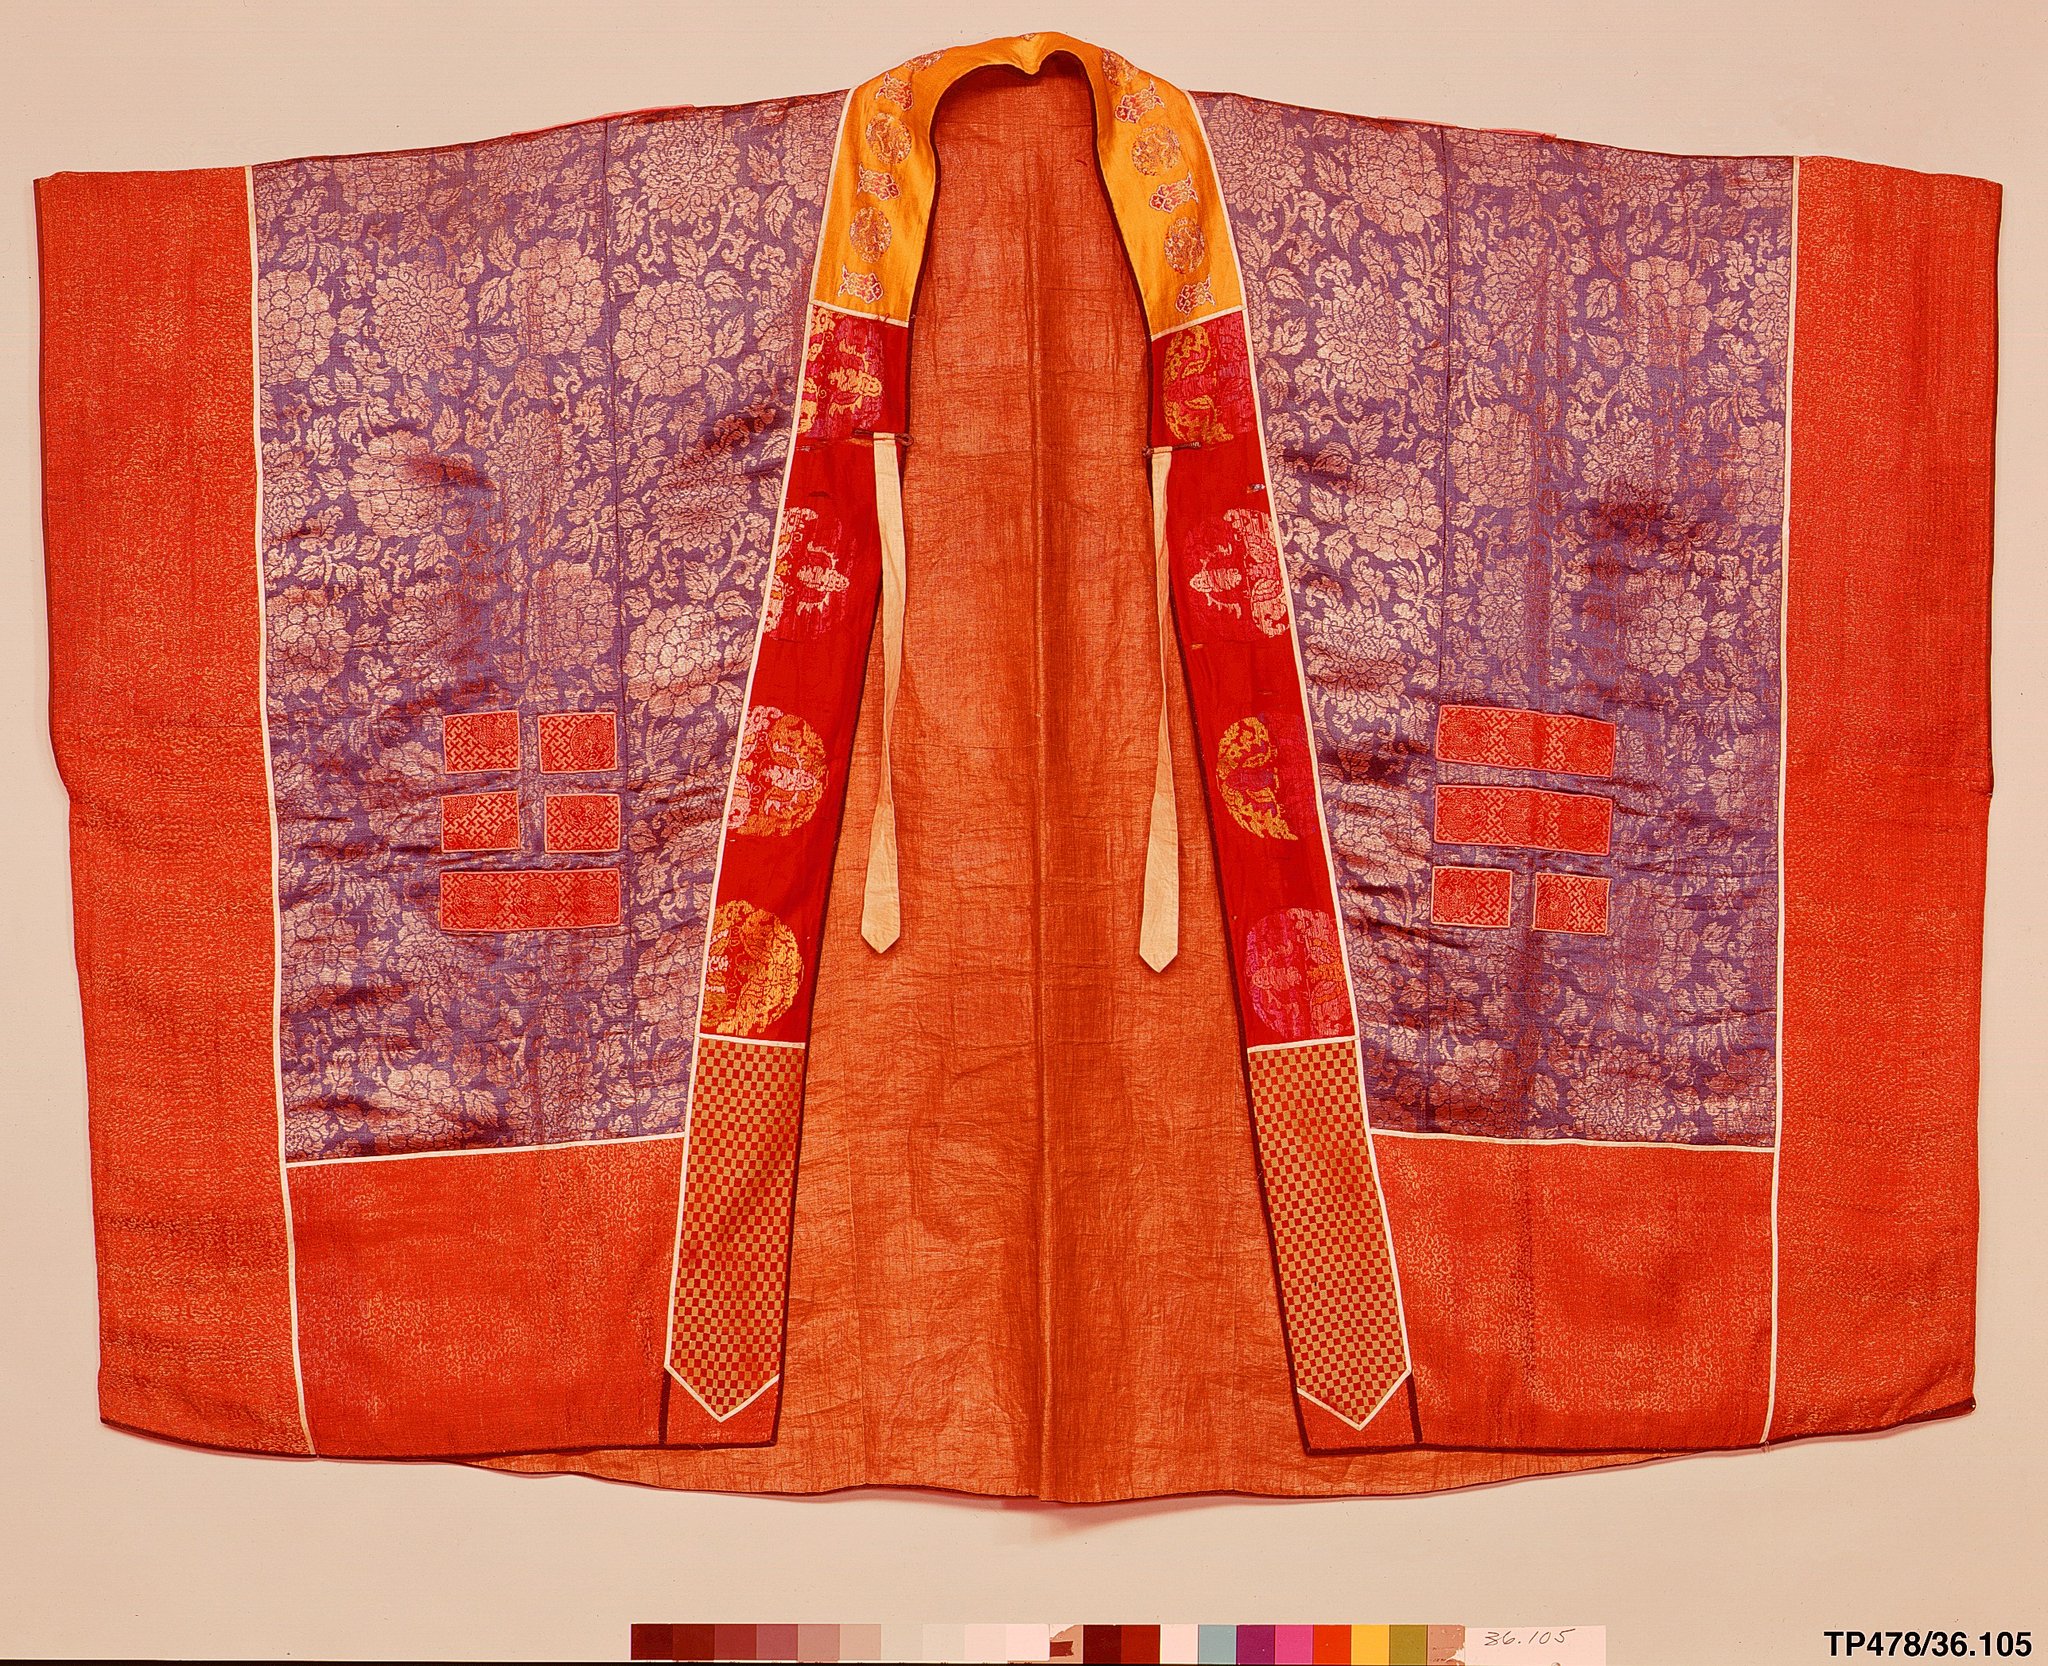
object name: robe, daoist priest's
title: Daoist Priest's Robe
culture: chinese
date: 1767-1833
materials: metal thread, silk